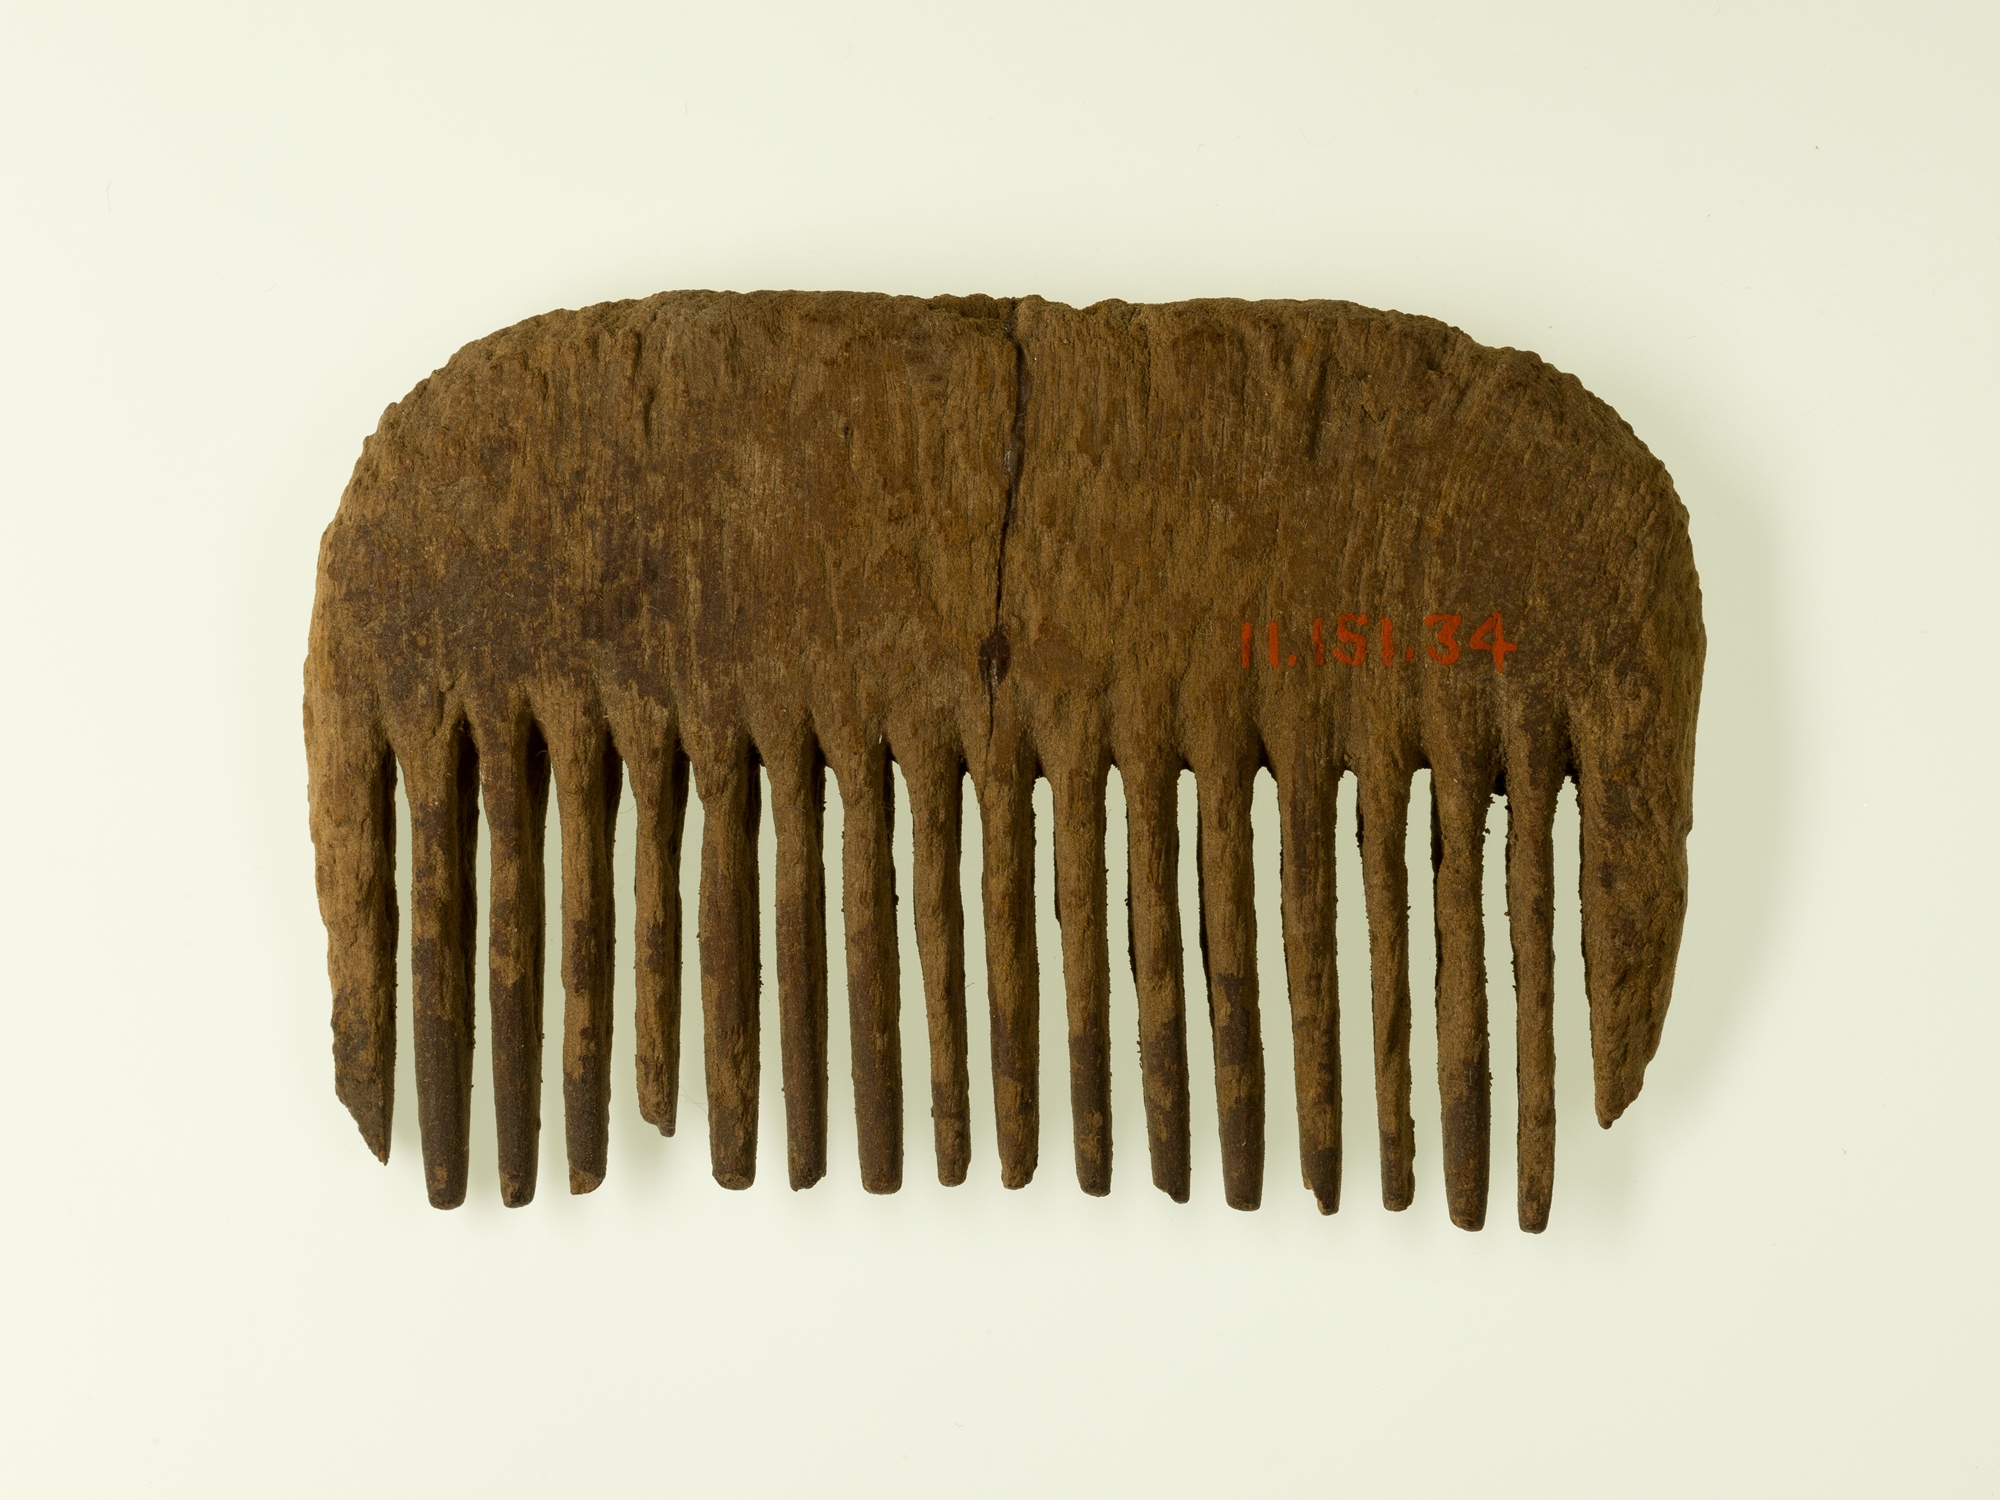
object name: comb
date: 1295-1070 BCE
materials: wood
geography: egypt